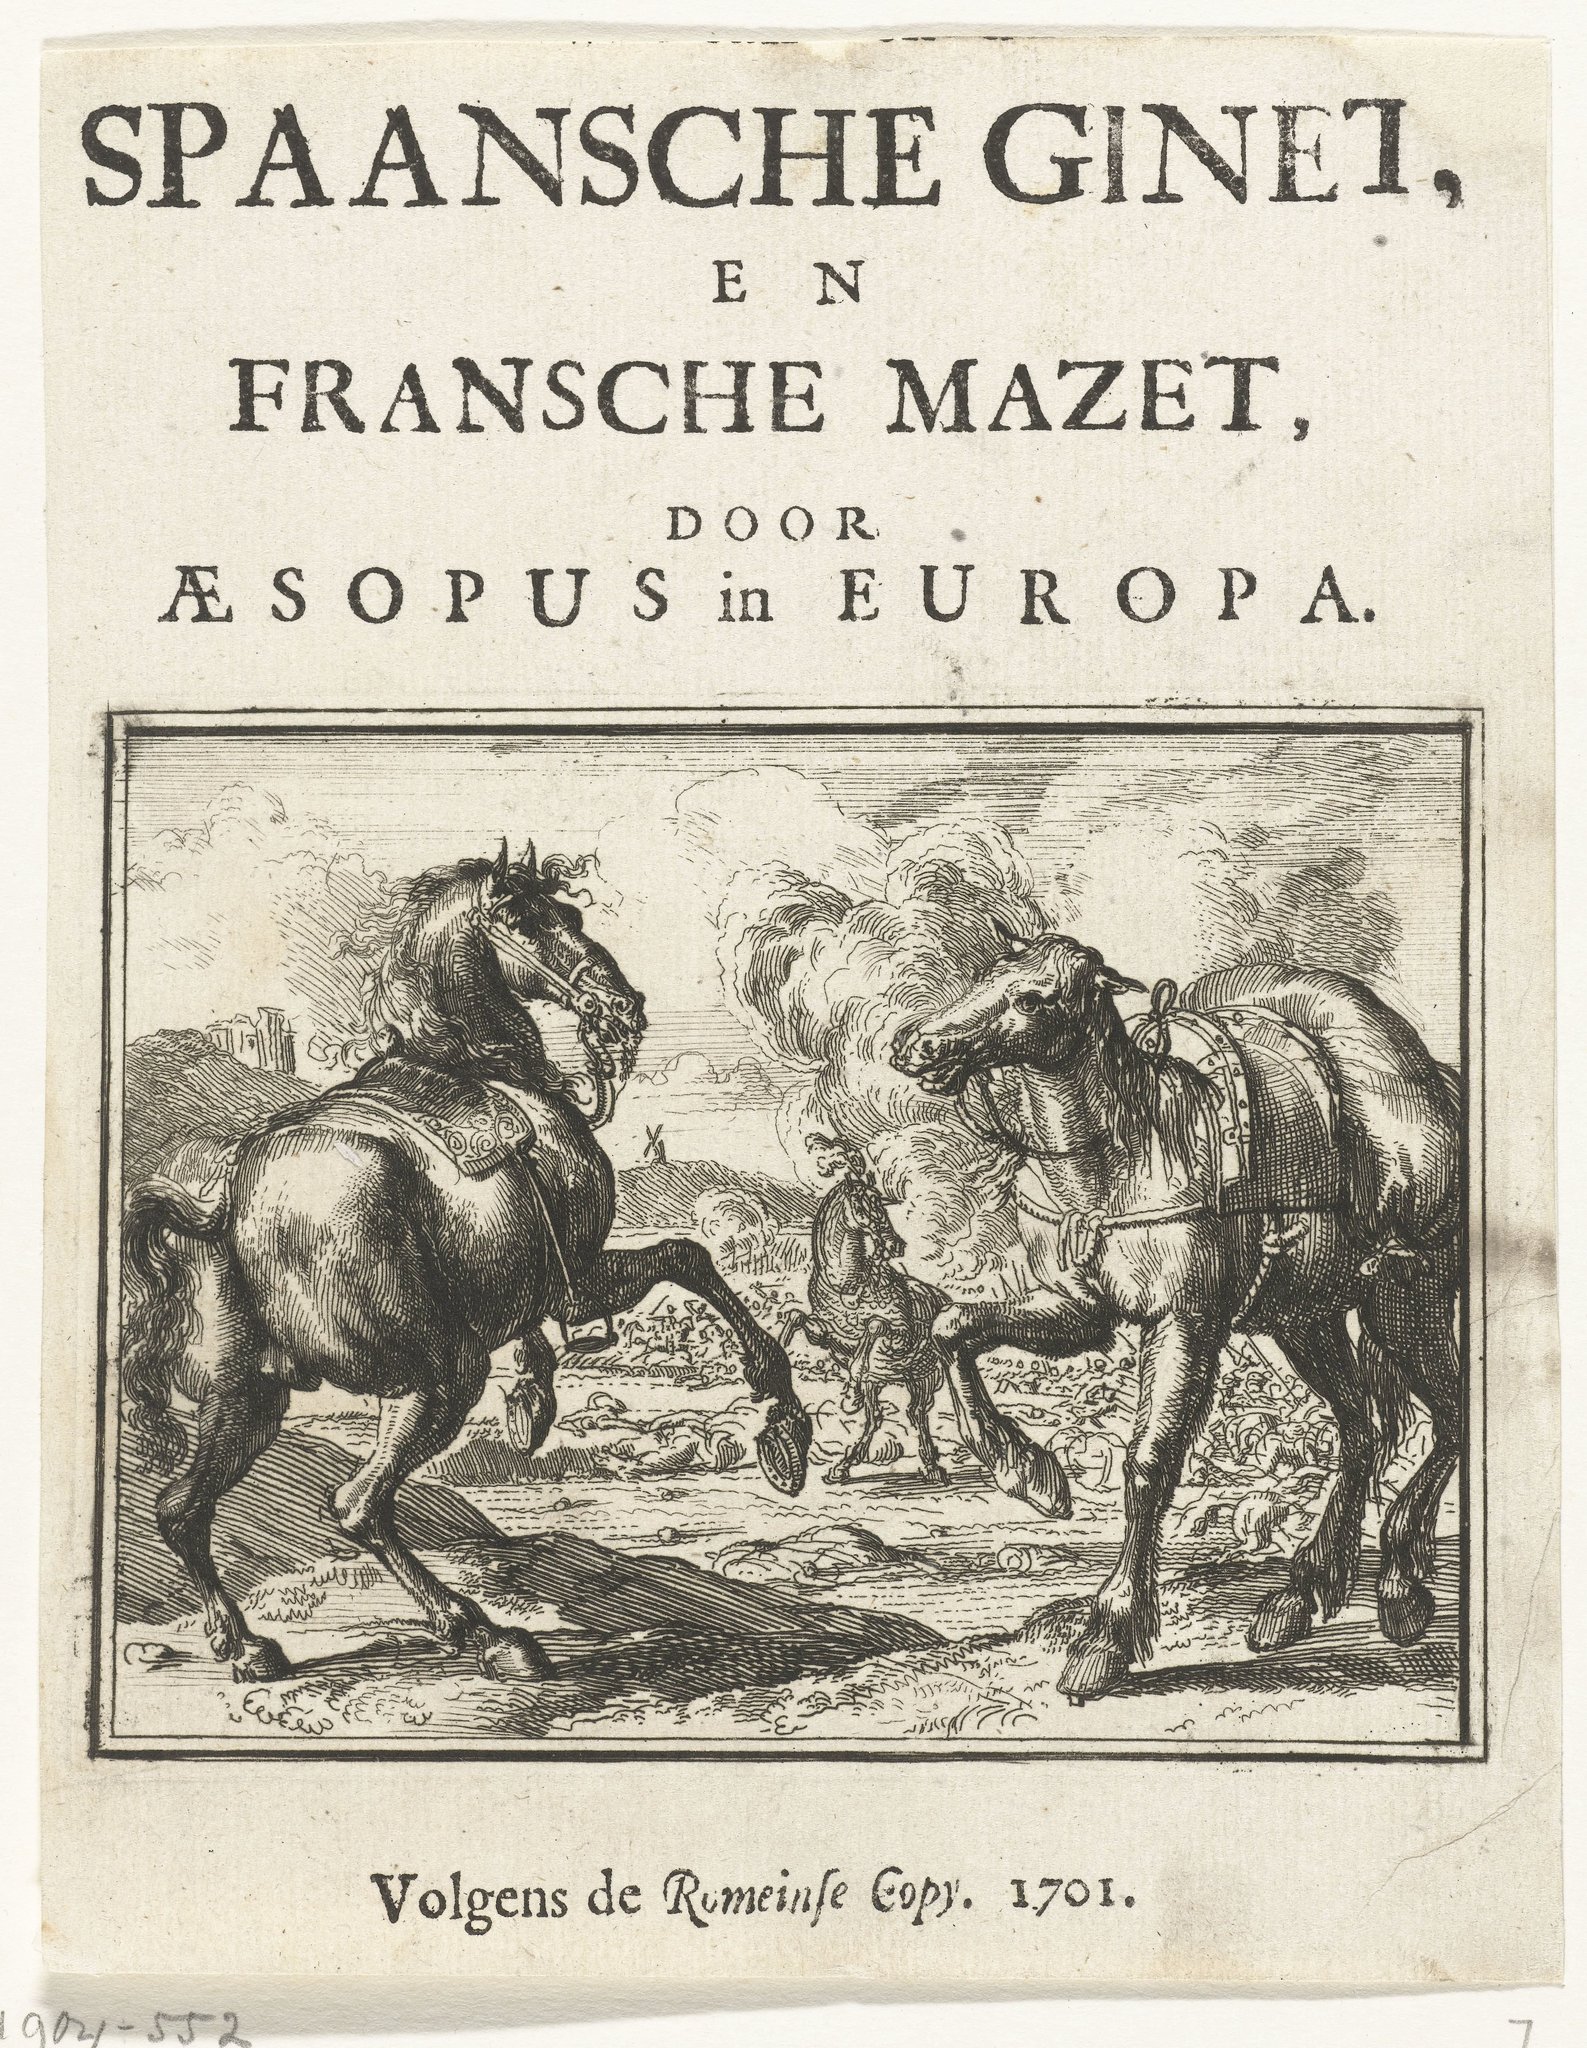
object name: print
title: Titelblad voor het pamflet: Twist tusschen de Spaansche Ginet en Fransche Mazet door Aesopus in Europa, 1701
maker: romeyn de hooghe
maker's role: draughtsman, goldsmith, painter, print maker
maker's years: 1645-1708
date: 1701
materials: paper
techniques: etching, letterpress printing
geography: northern netherlands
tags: spaanse successieoorlog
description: Titelblad voor het pamflet: Twist tusschen de Spaansche Ginet en Fransche Mazet door Aesopus in Europa, 1701. Een Spaans en een Frans paard zonder berijders voor een slagveld. De paarden twisten over de rangorde tussen Spanje en Frankrijk.